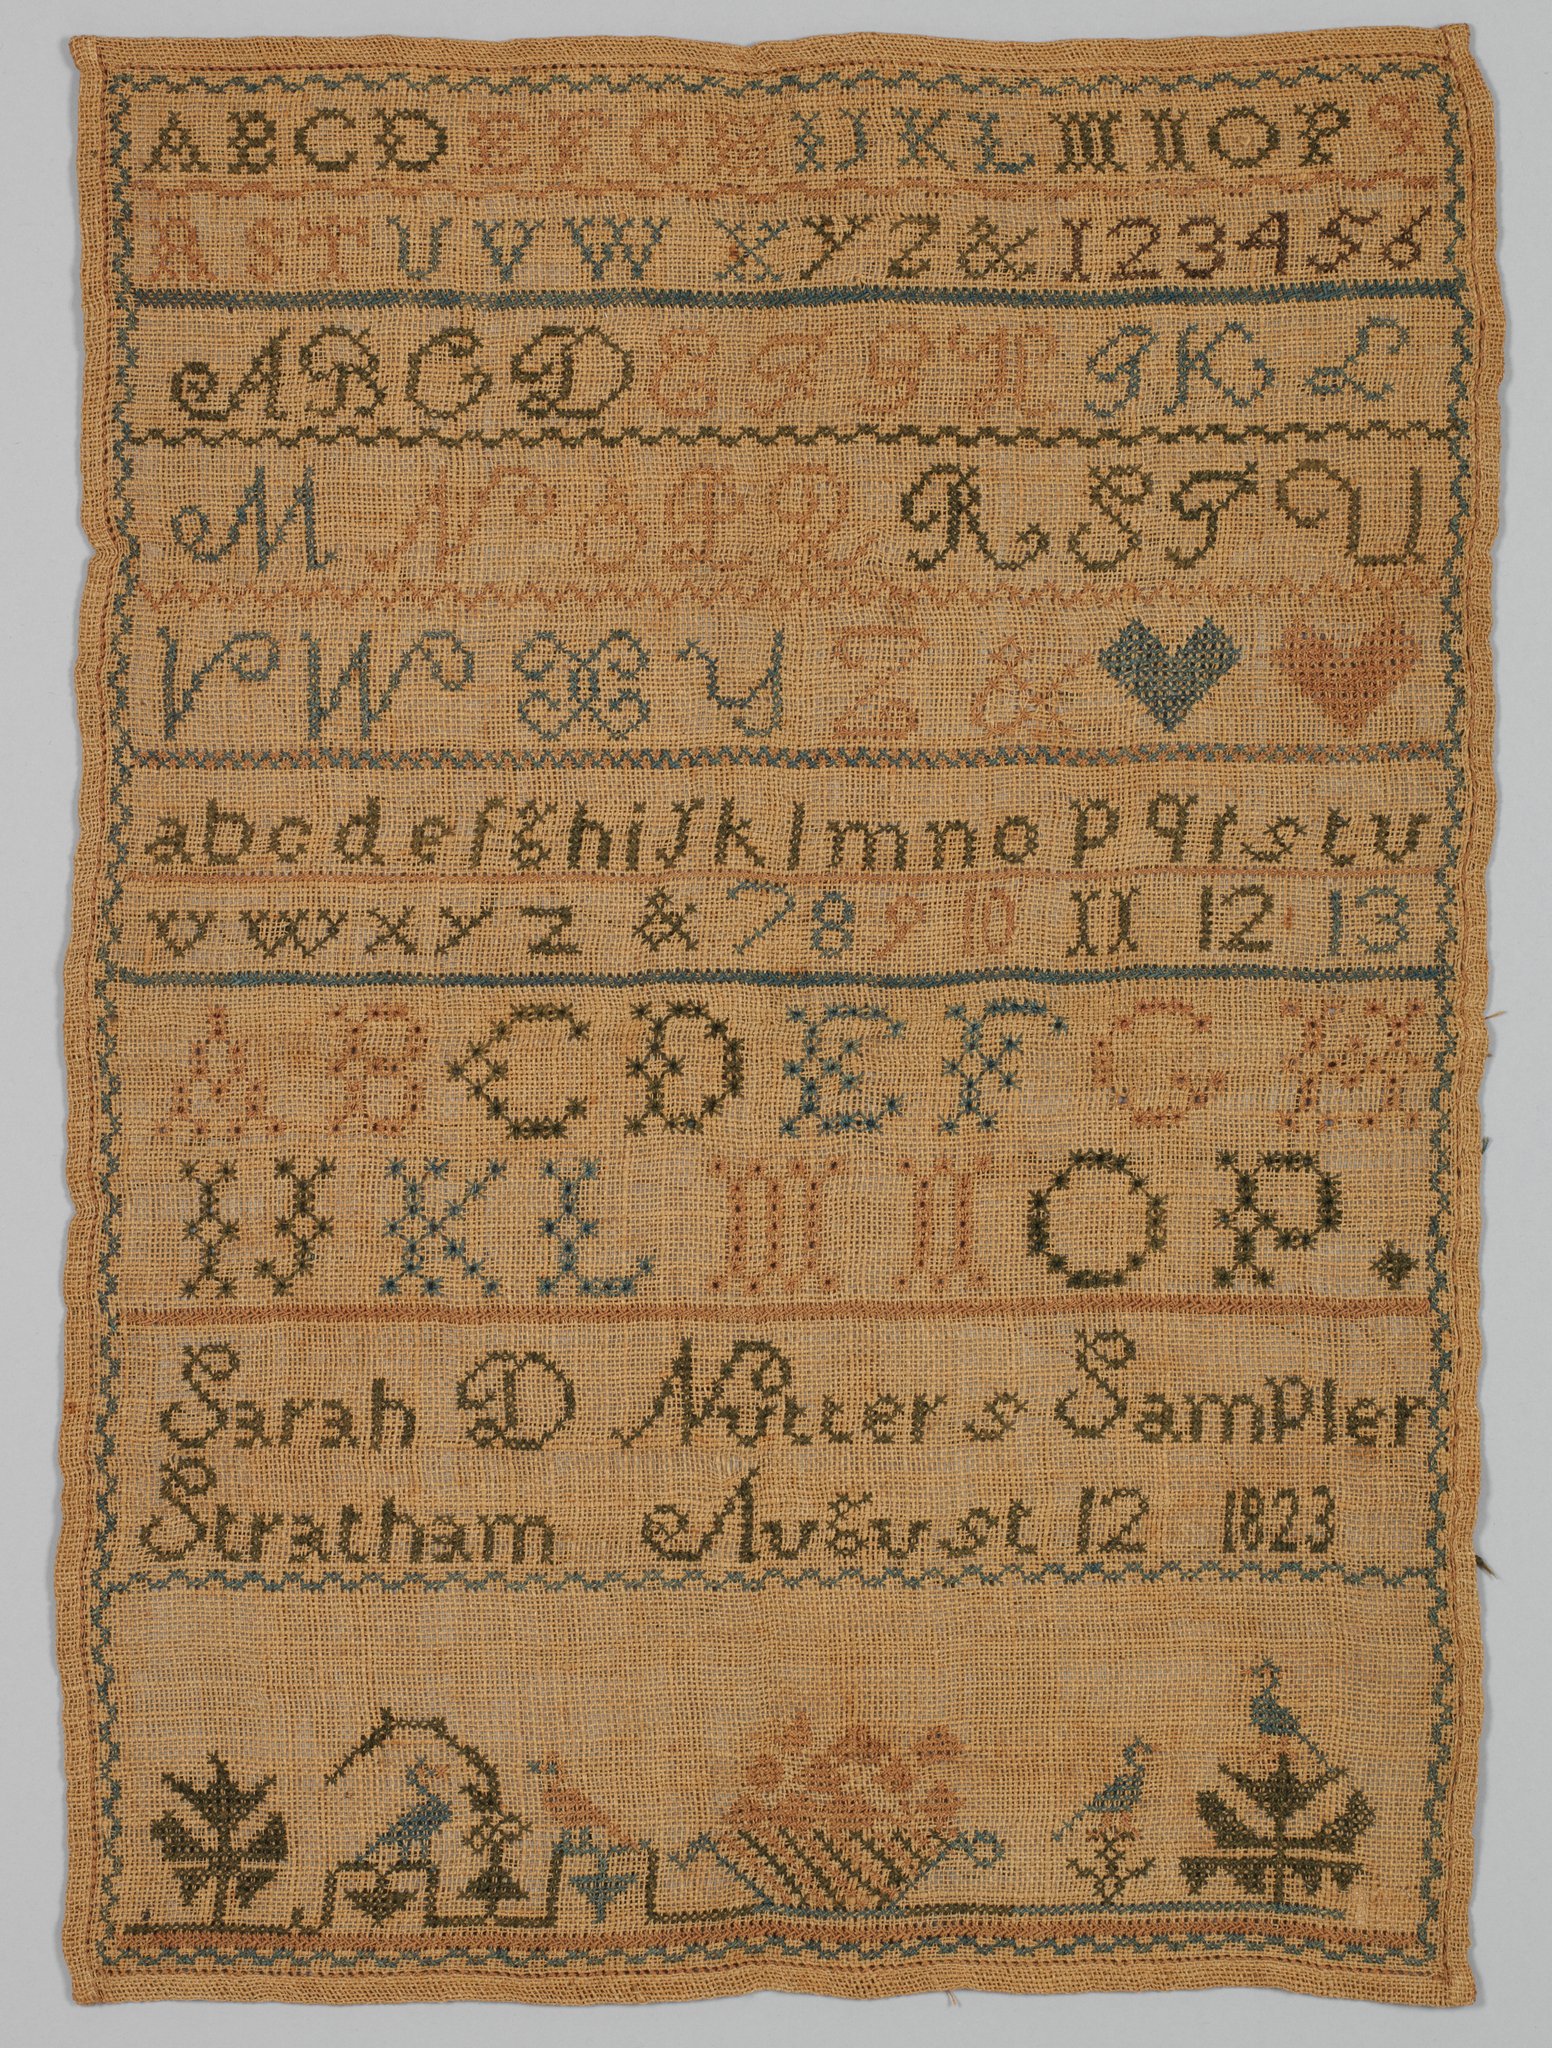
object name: sampler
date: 1823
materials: canvas, cotton, linen